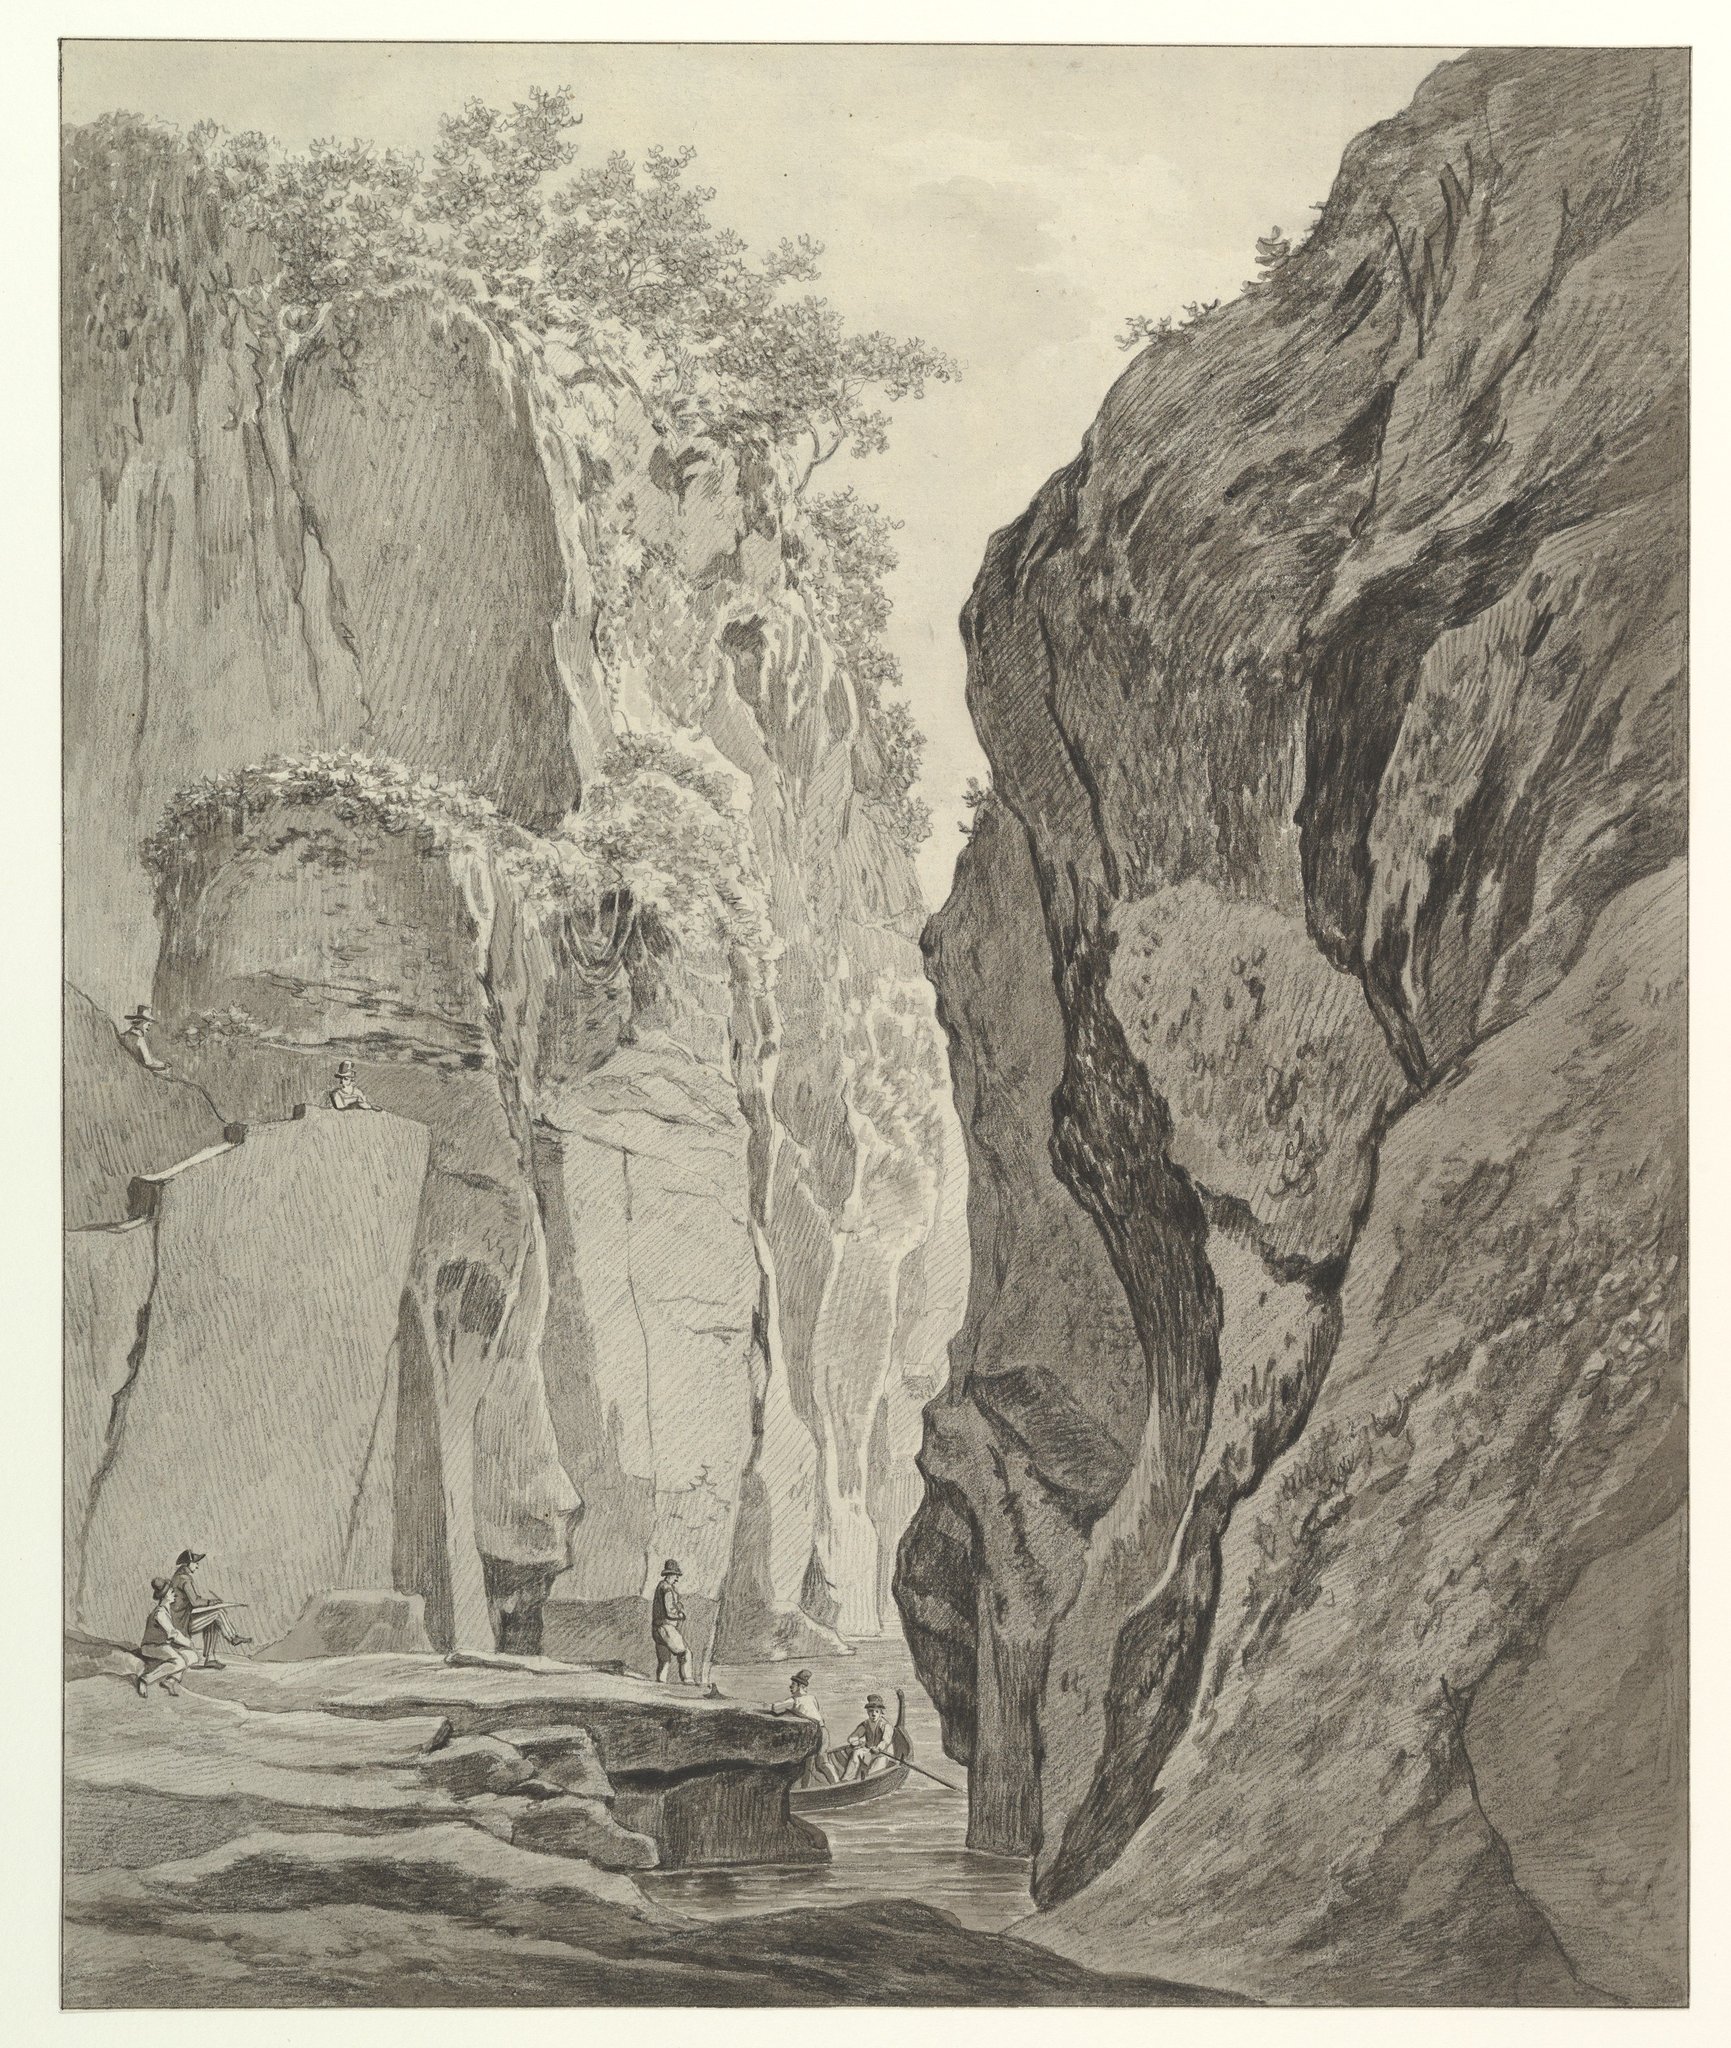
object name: drawing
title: Figures Boating in a Gorge near Sorrento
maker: daniël dupré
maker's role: artist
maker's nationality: dutch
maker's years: 1751-1817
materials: chalk, ink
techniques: brush, pen, wash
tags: human figures,hills,boats